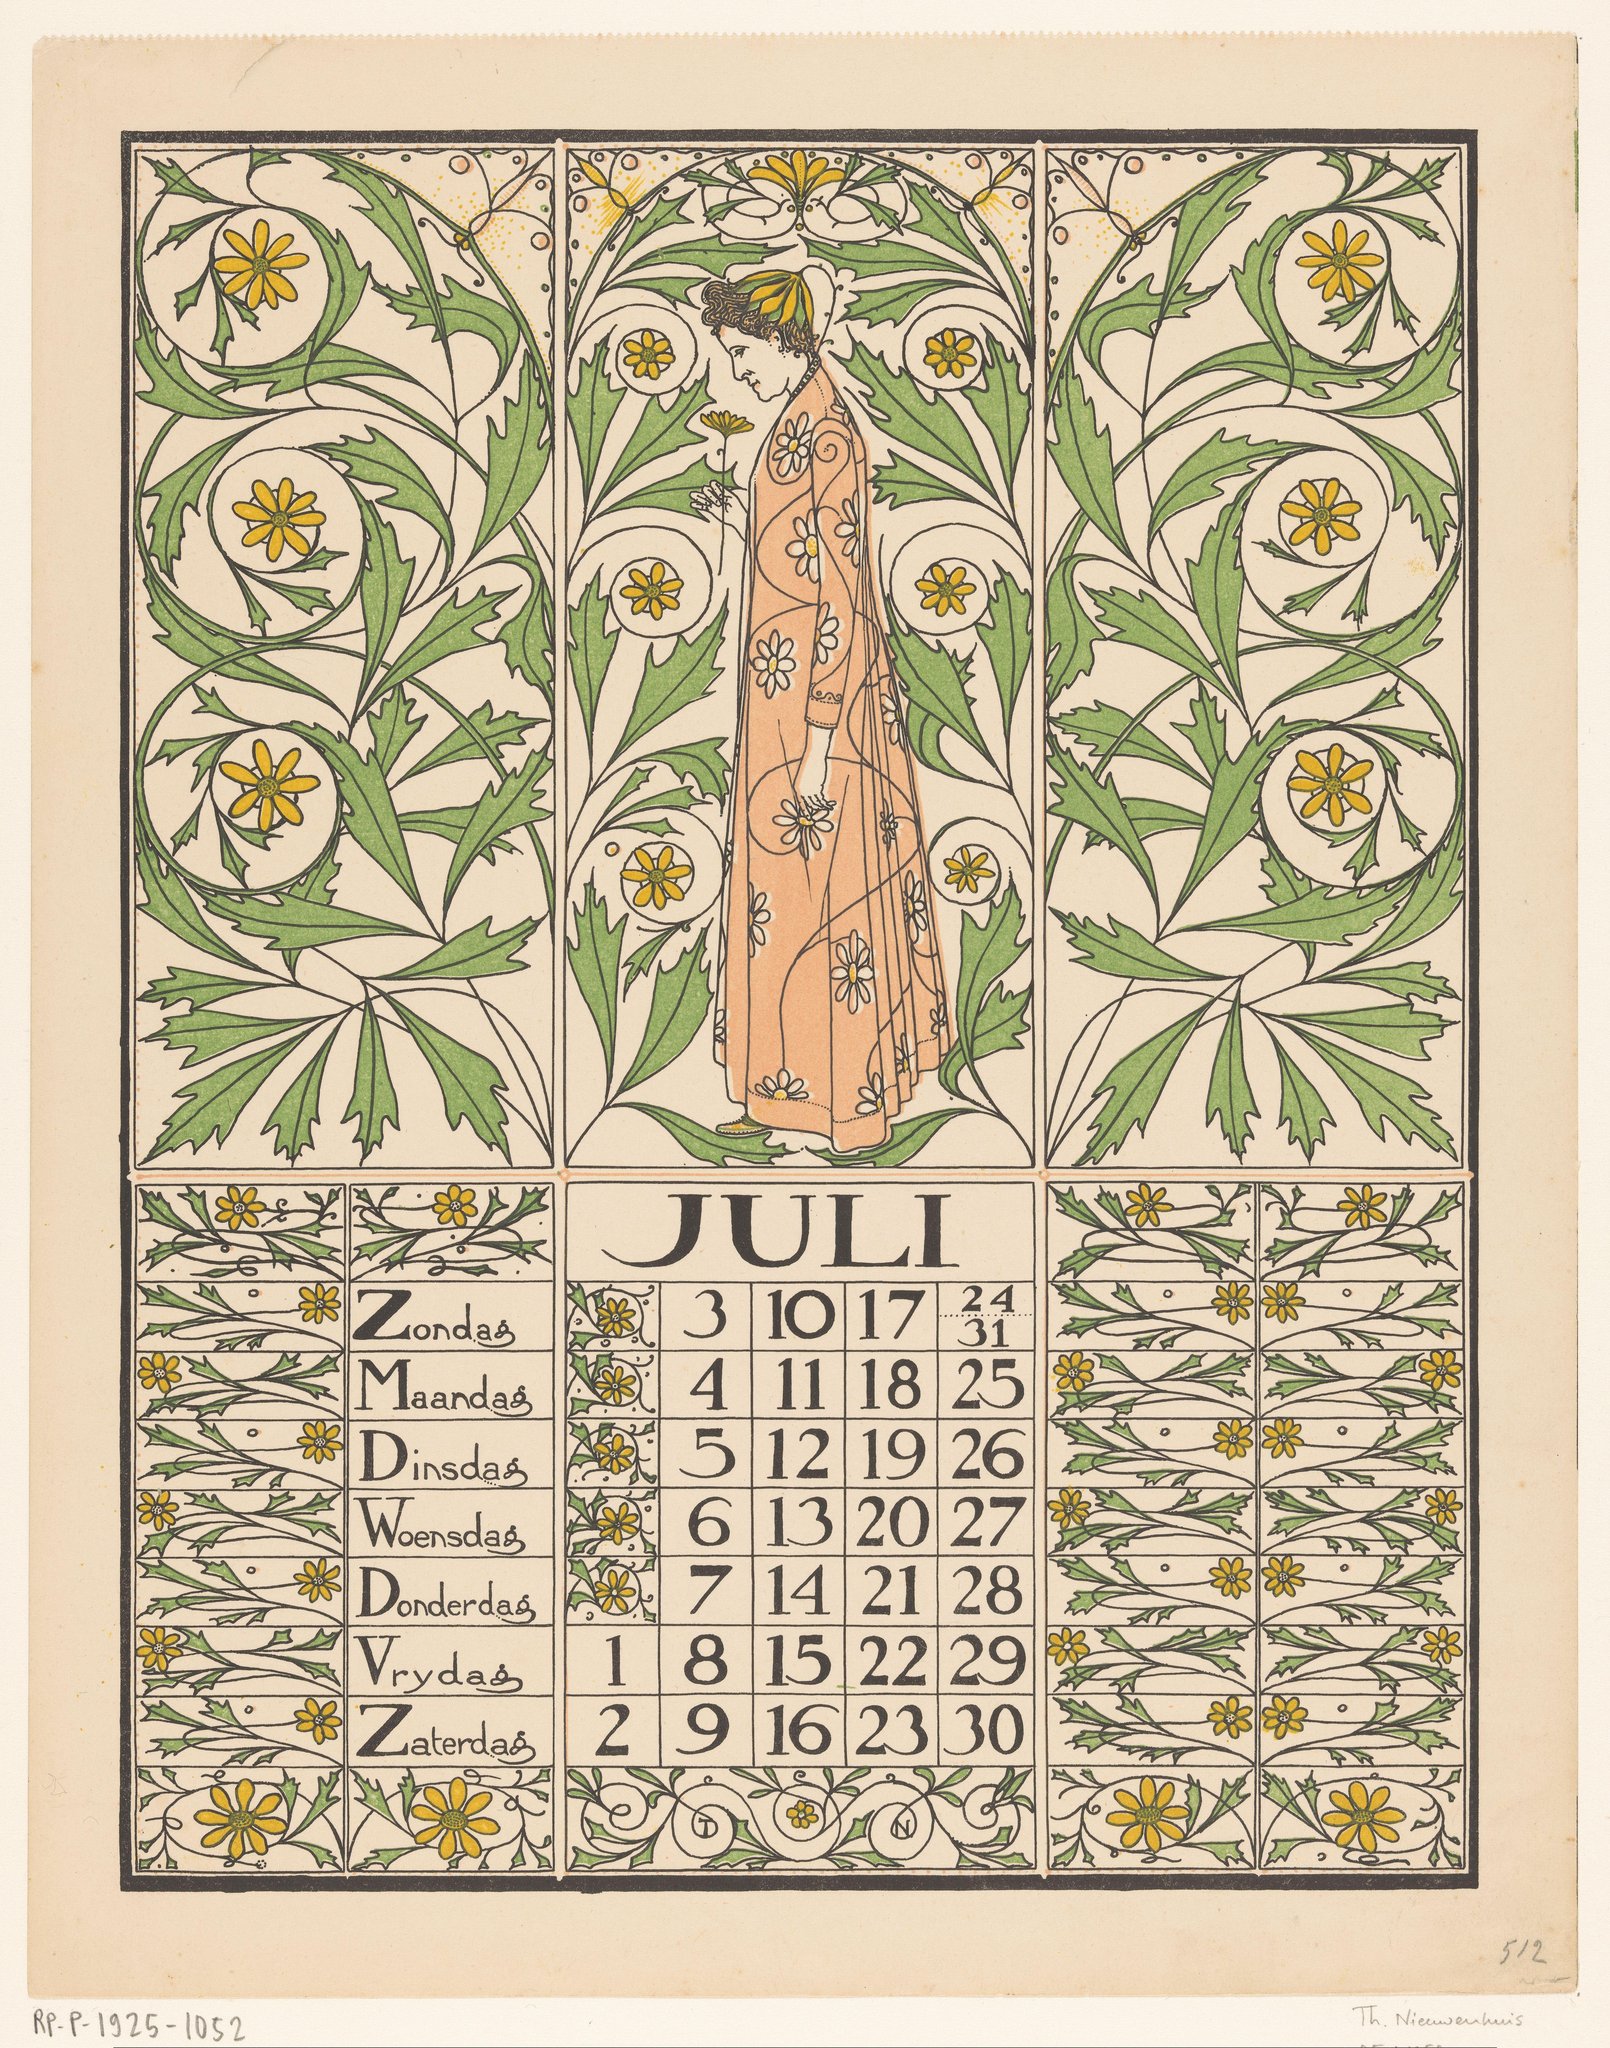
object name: print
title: Kalenderblad voor juli 1898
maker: theo nieuwenhuis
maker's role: designer, draughtsman, print maker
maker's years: 1866-1951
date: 1897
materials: paper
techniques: lithograph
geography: amsterdam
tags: flowers, insects: butterfly, dress, gown, ornament derived from plant forms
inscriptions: collector's mark: Lugt 2228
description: Een rechthoekig kader opgevuld met de dagen van de maand juli en daaromheen bloemen, bladeren, vlinders en een vrouw in een bebloemd gewaad die een bloem vasthoudt.